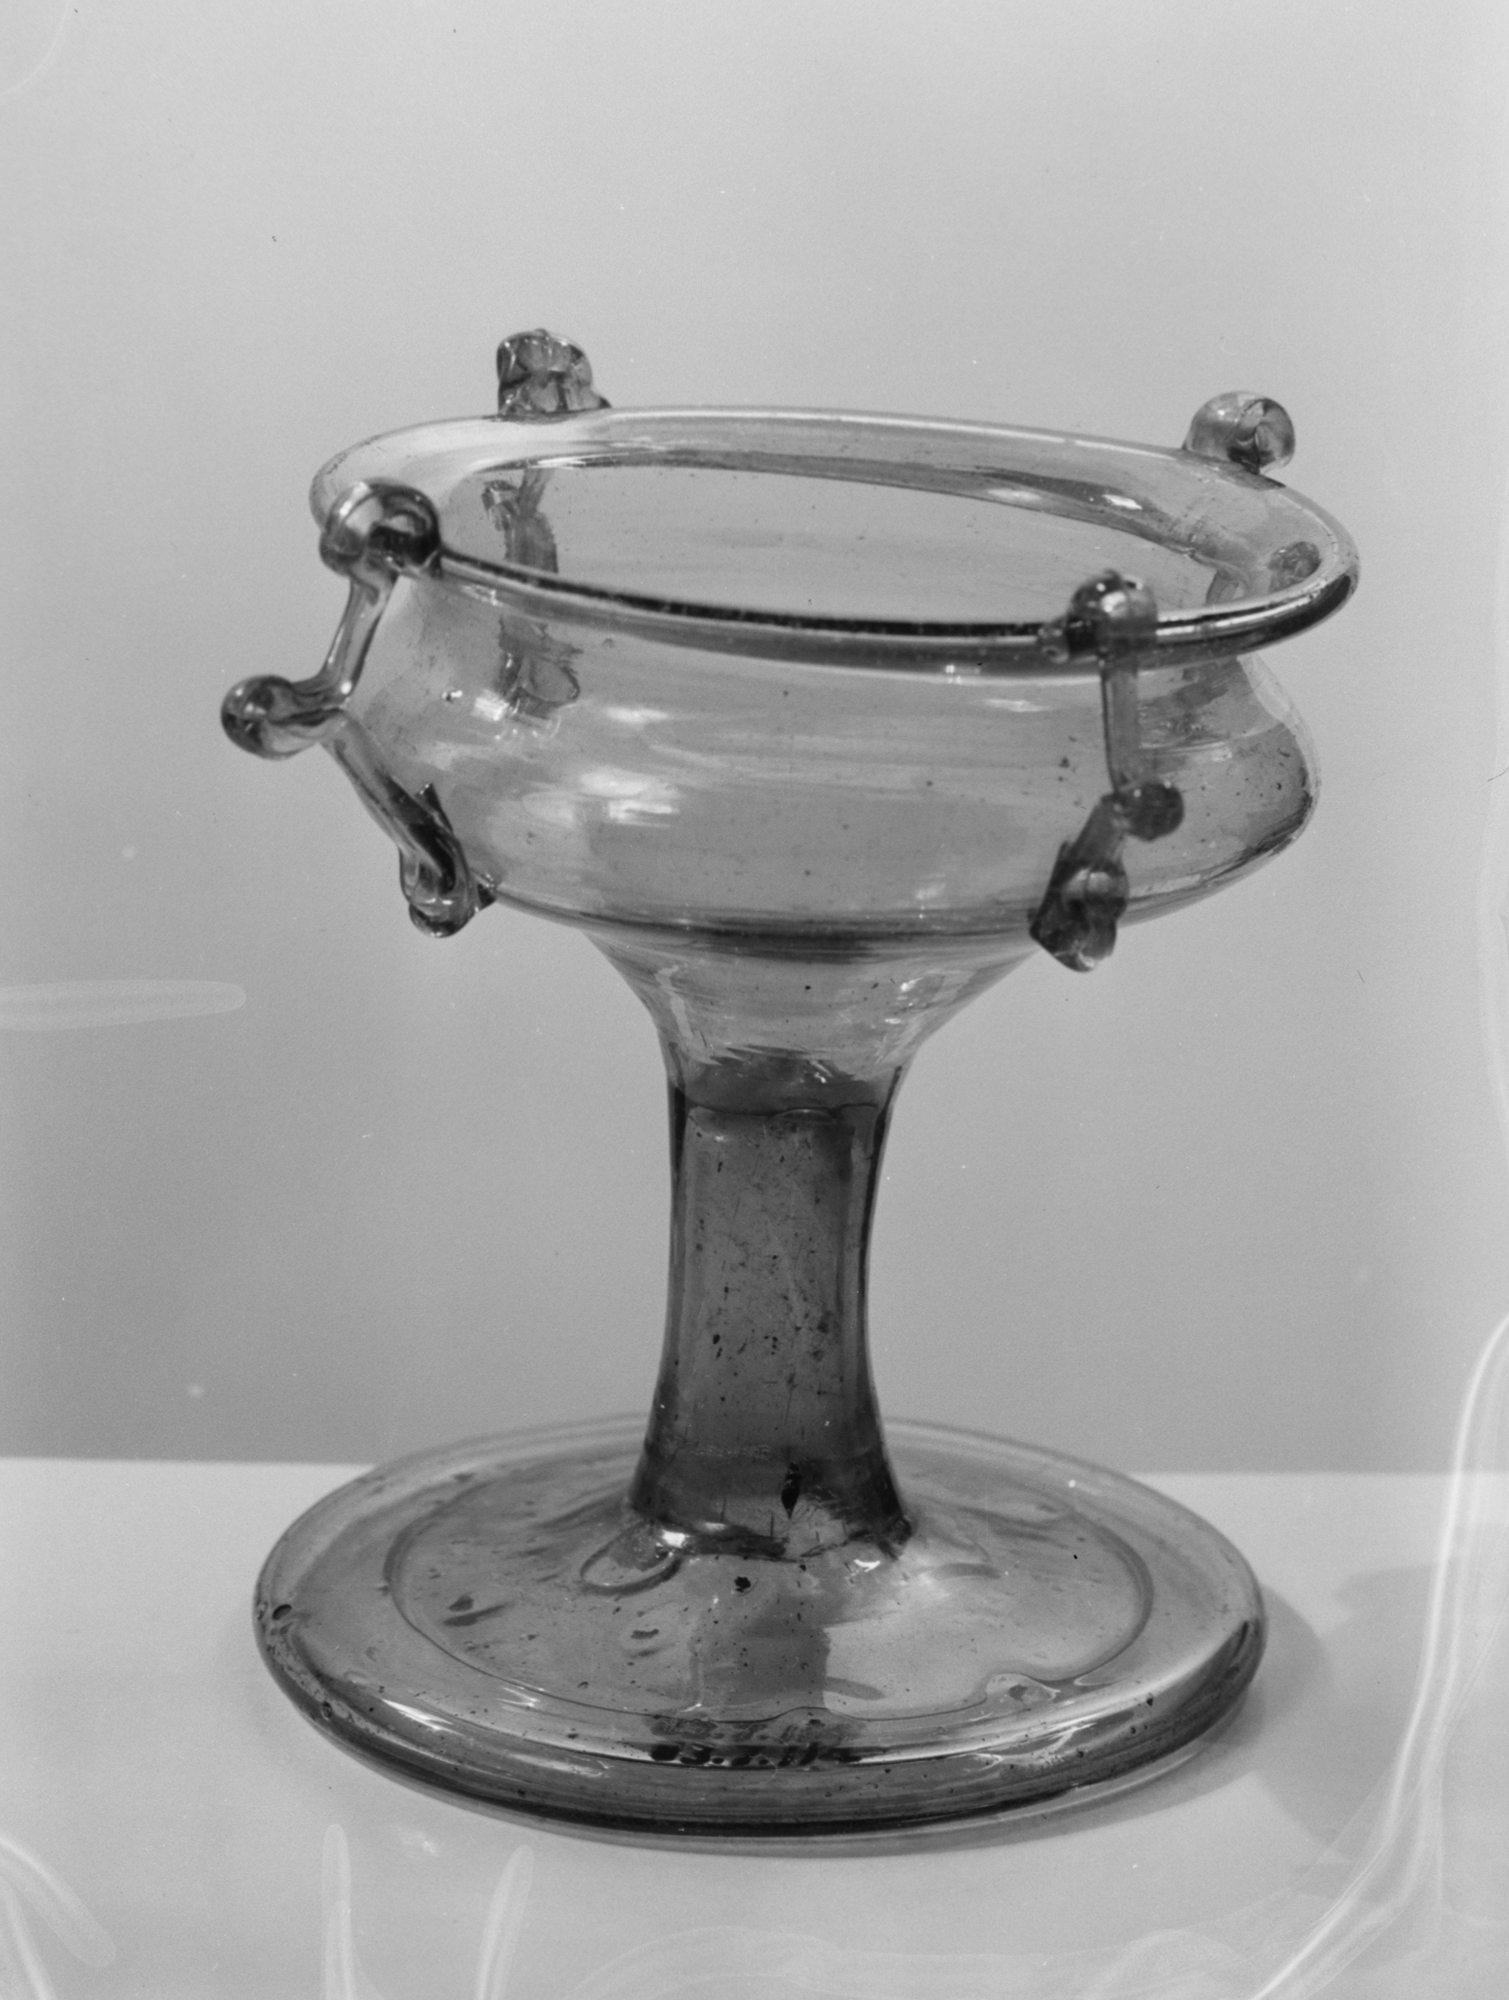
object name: saltcellar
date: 1601-1800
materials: glass